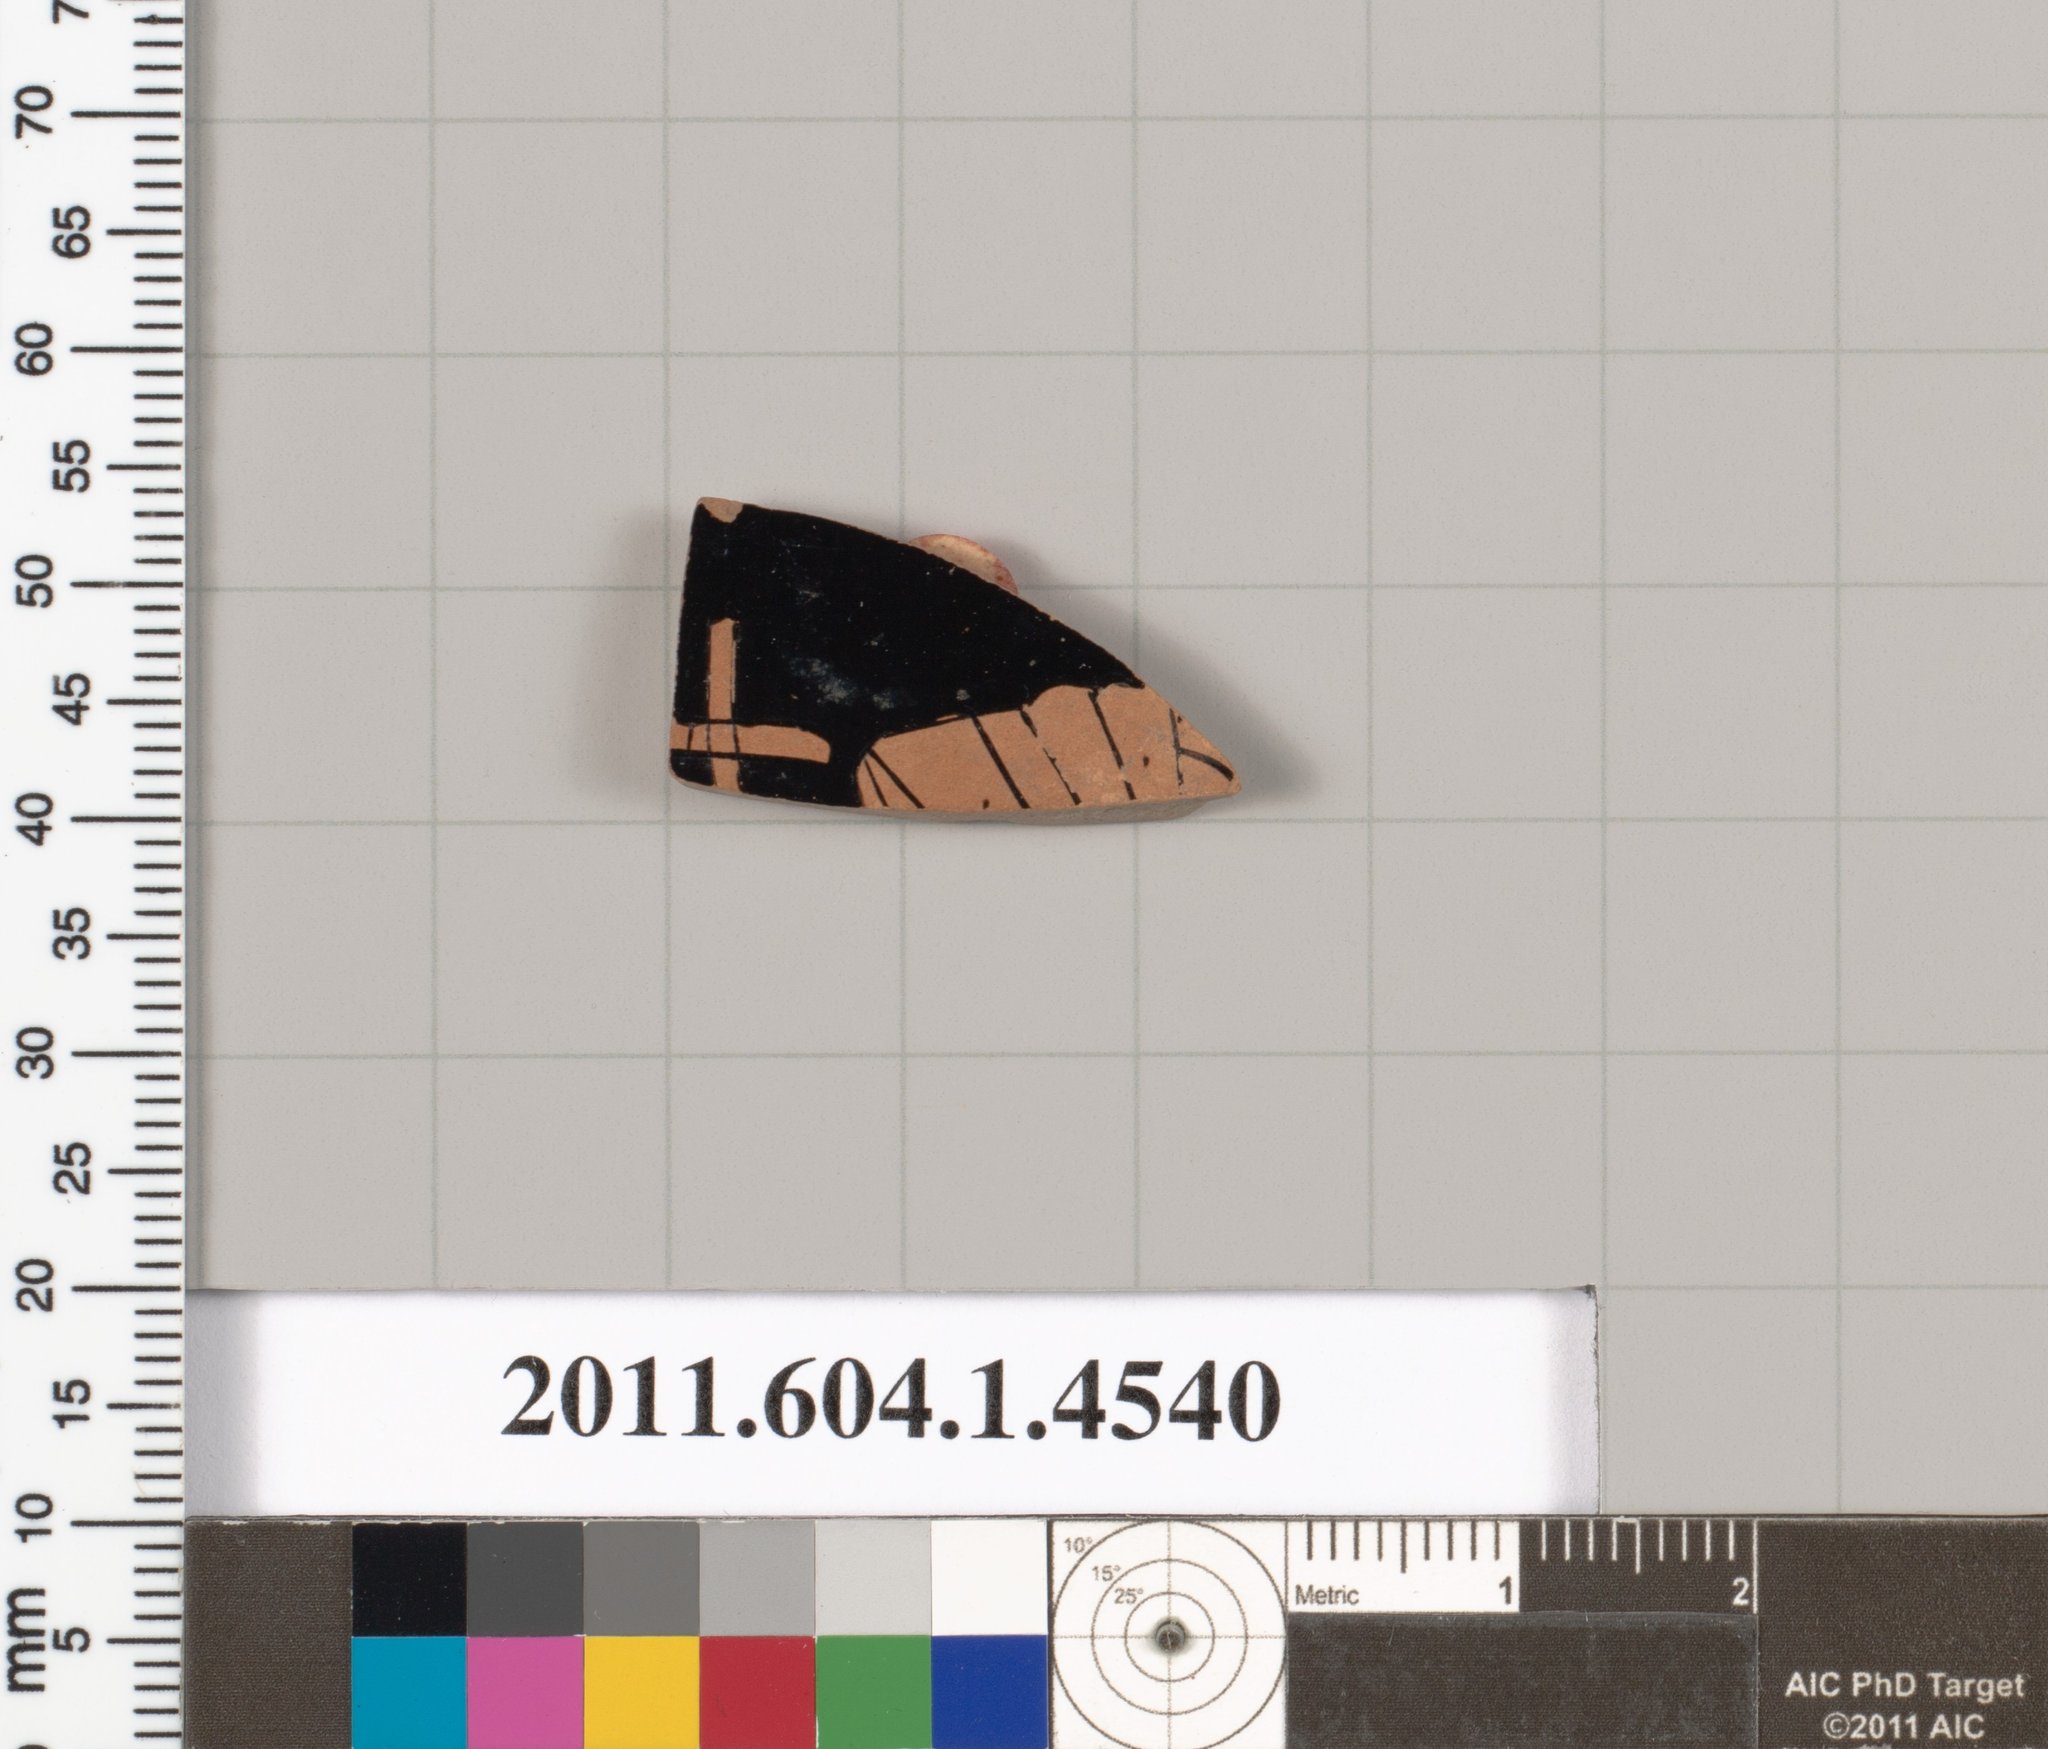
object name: kylix fragment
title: Terracotta fragment of a kylix (drinking cup)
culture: greek, attic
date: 490-470 BCE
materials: terracotta